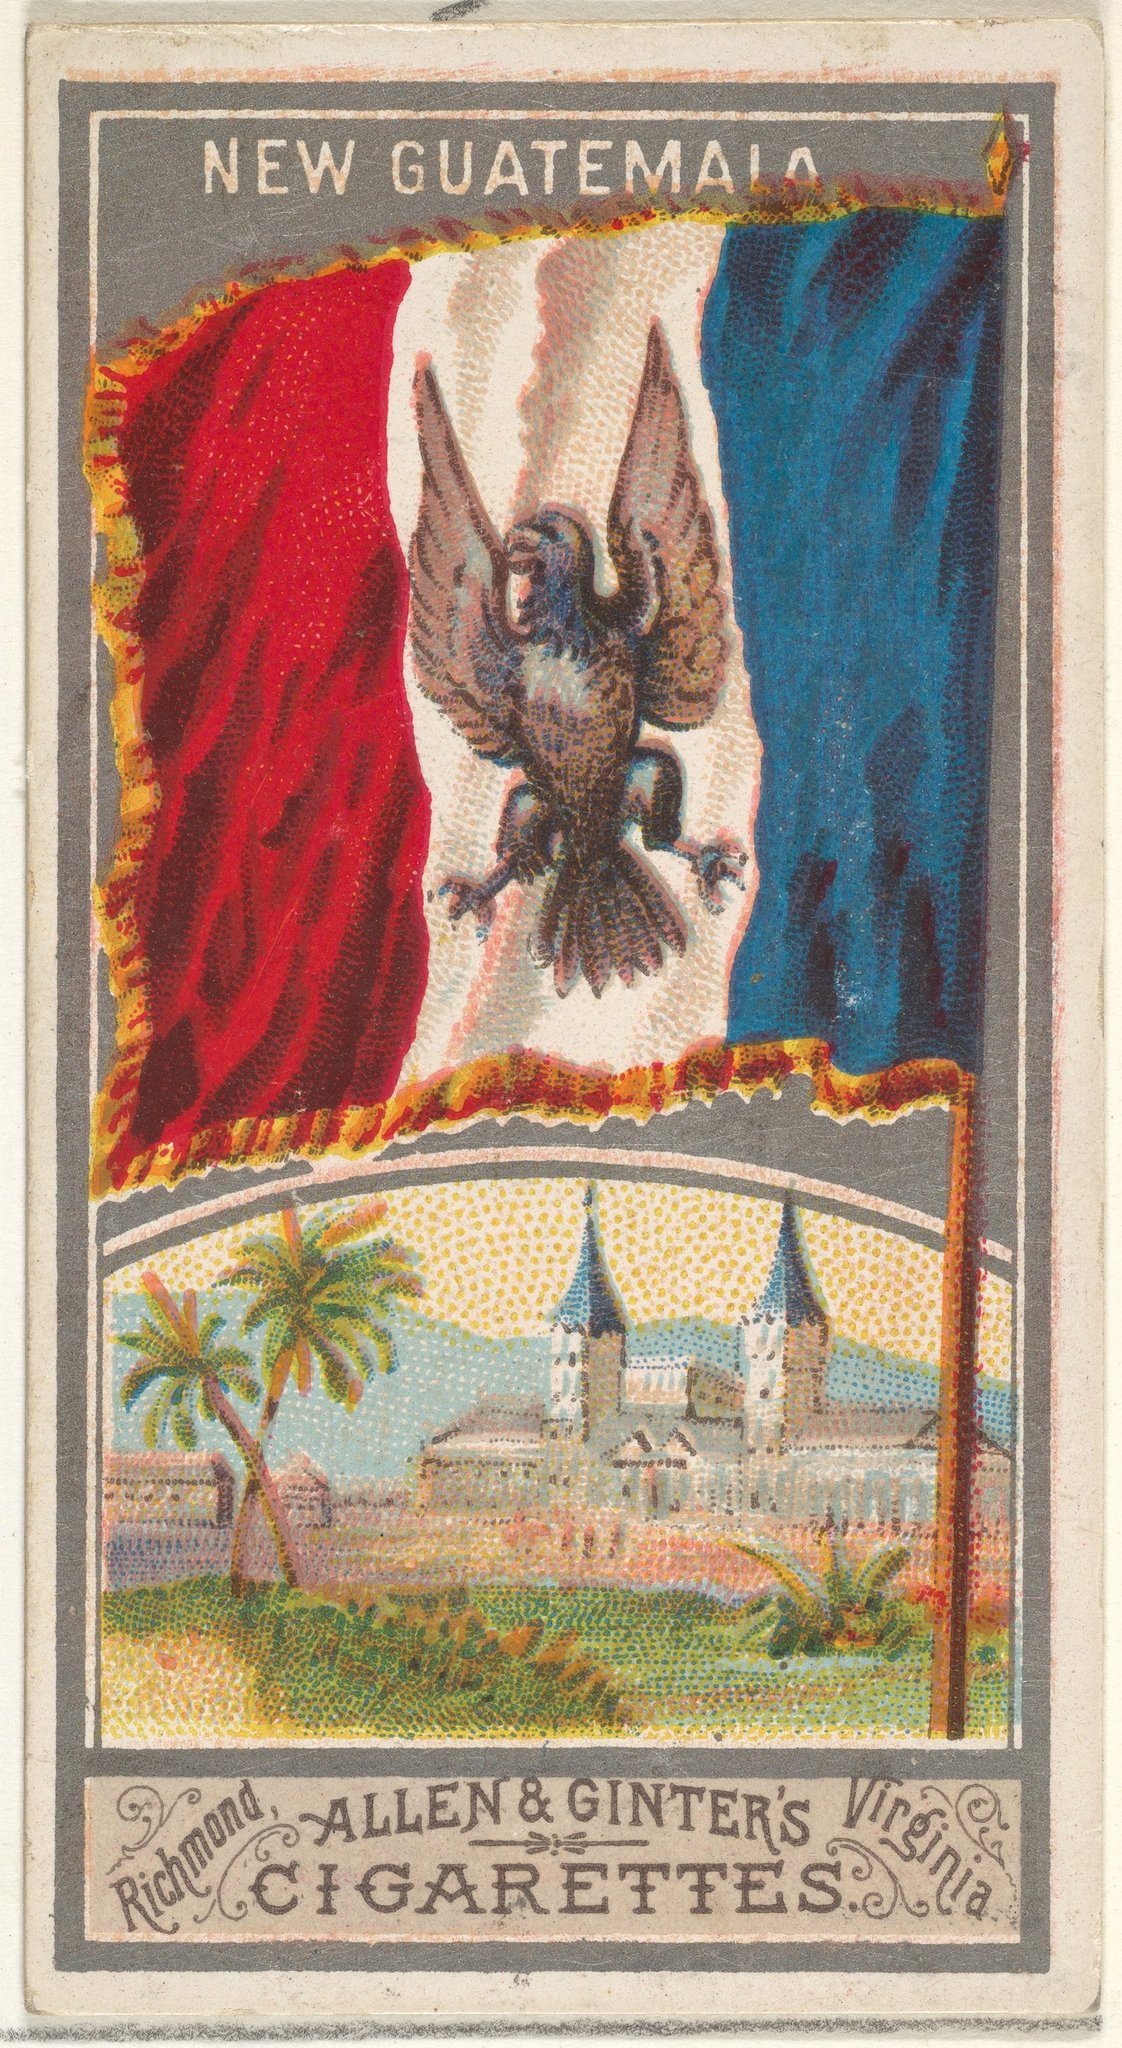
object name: print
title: New Guatemala, from the City Flags series (N6) for Allen & Ginter Cigarettes Brands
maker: allen & ginter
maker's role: publisher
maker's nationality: american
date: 1887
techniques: color lithograph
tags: eagles,flags